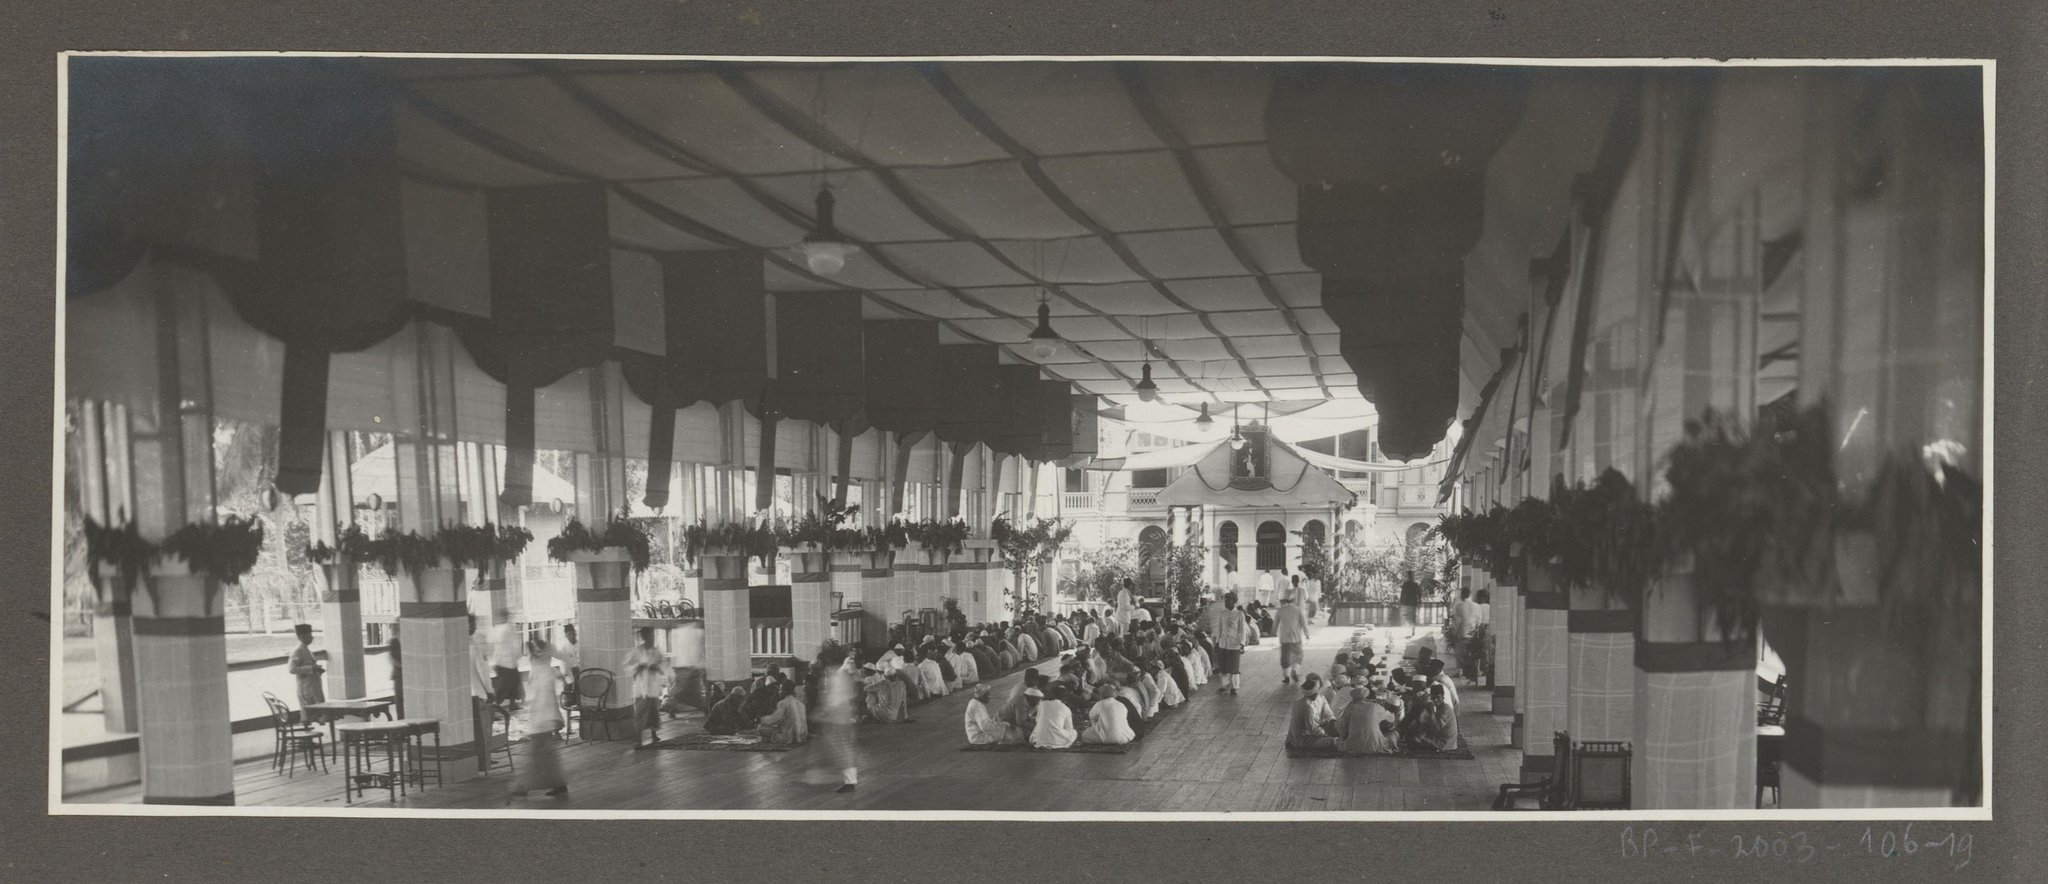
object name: album leaf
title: Panorama van de ontvangstzaal in het paleis van de Sultan van Langkat met mannen op tapijten op de grond gezeten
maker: Anonymous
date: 1919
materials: photographic support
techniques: gelatin silver print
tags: palace - aa - civic architecture: inside, historical persons, sitting on the ground, sumatra